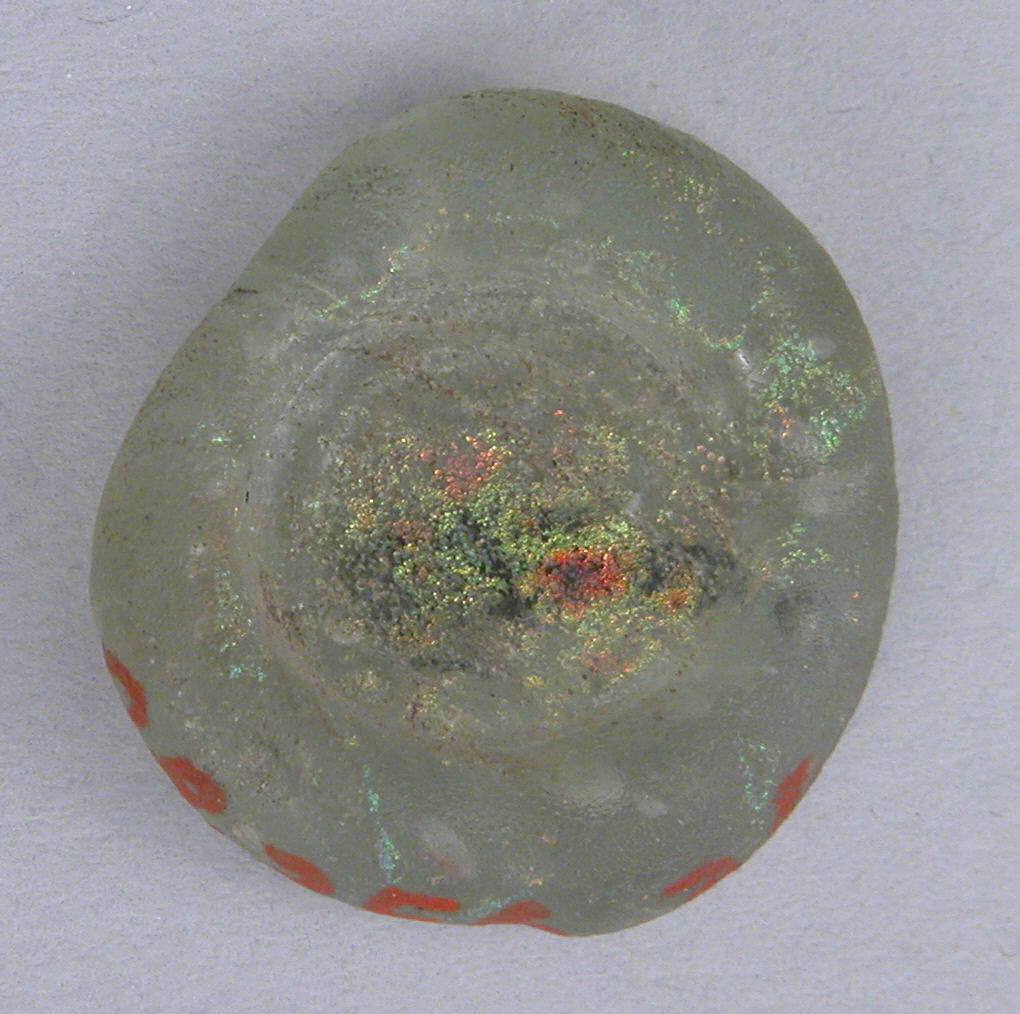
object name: coin weight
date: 1201-1600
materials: glass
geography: egypt